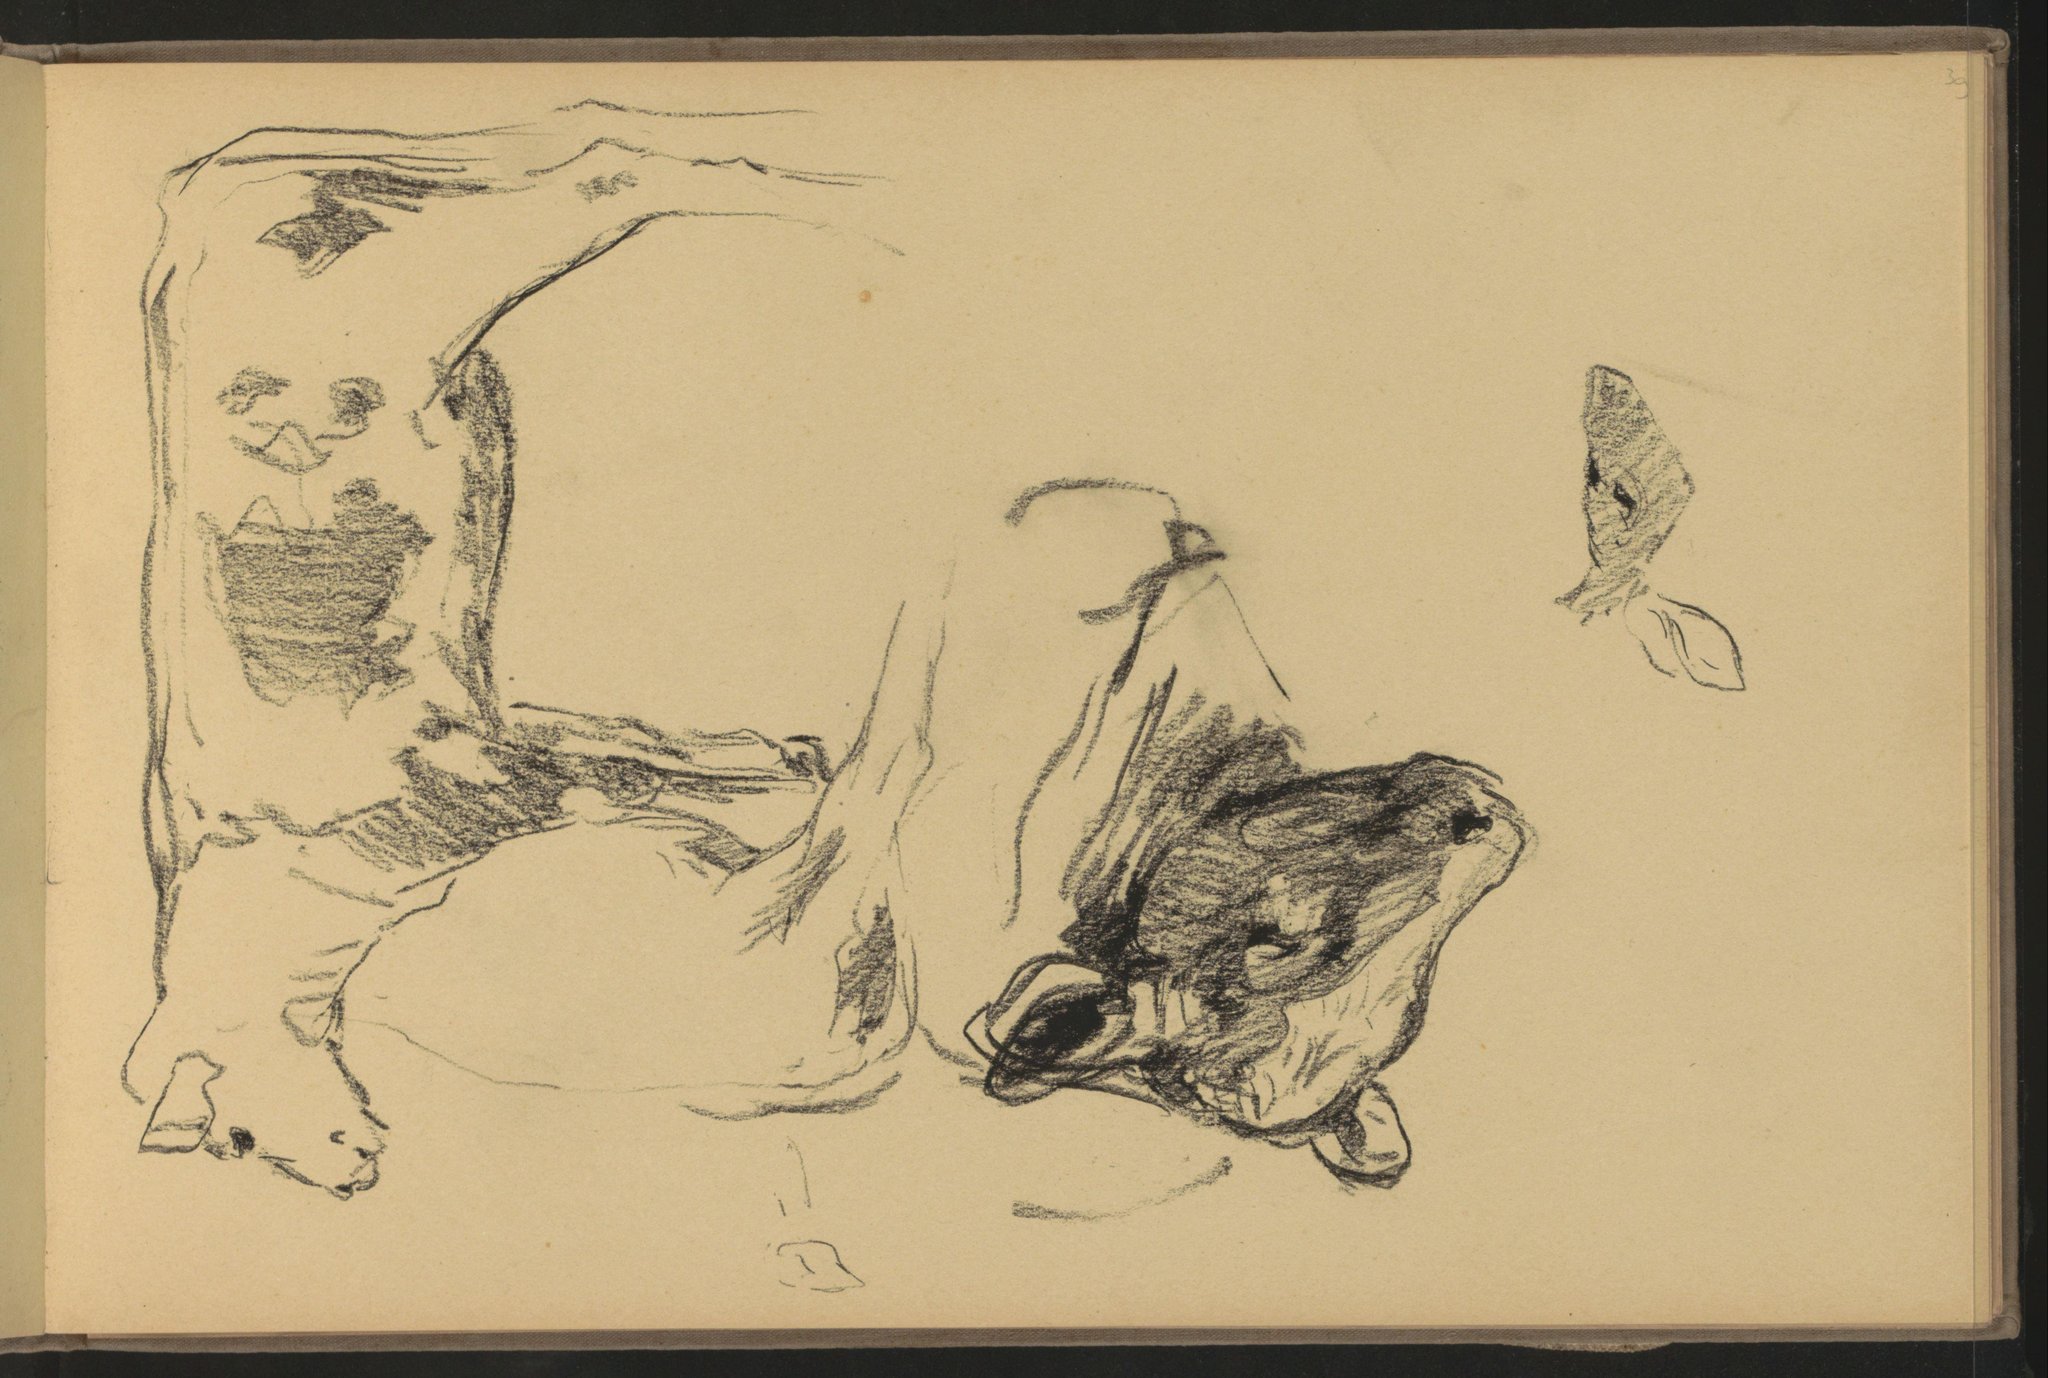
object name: sketchbook leaf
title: Studieblad met koeien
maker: willem witsen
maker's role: draughtsman, painter, print maker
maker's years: 1860-1923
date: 1901-1907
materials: chalk, paper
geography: wijk bij duurstede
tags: cow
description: Pagina 39 uit een schetsboek met 60 bladen.